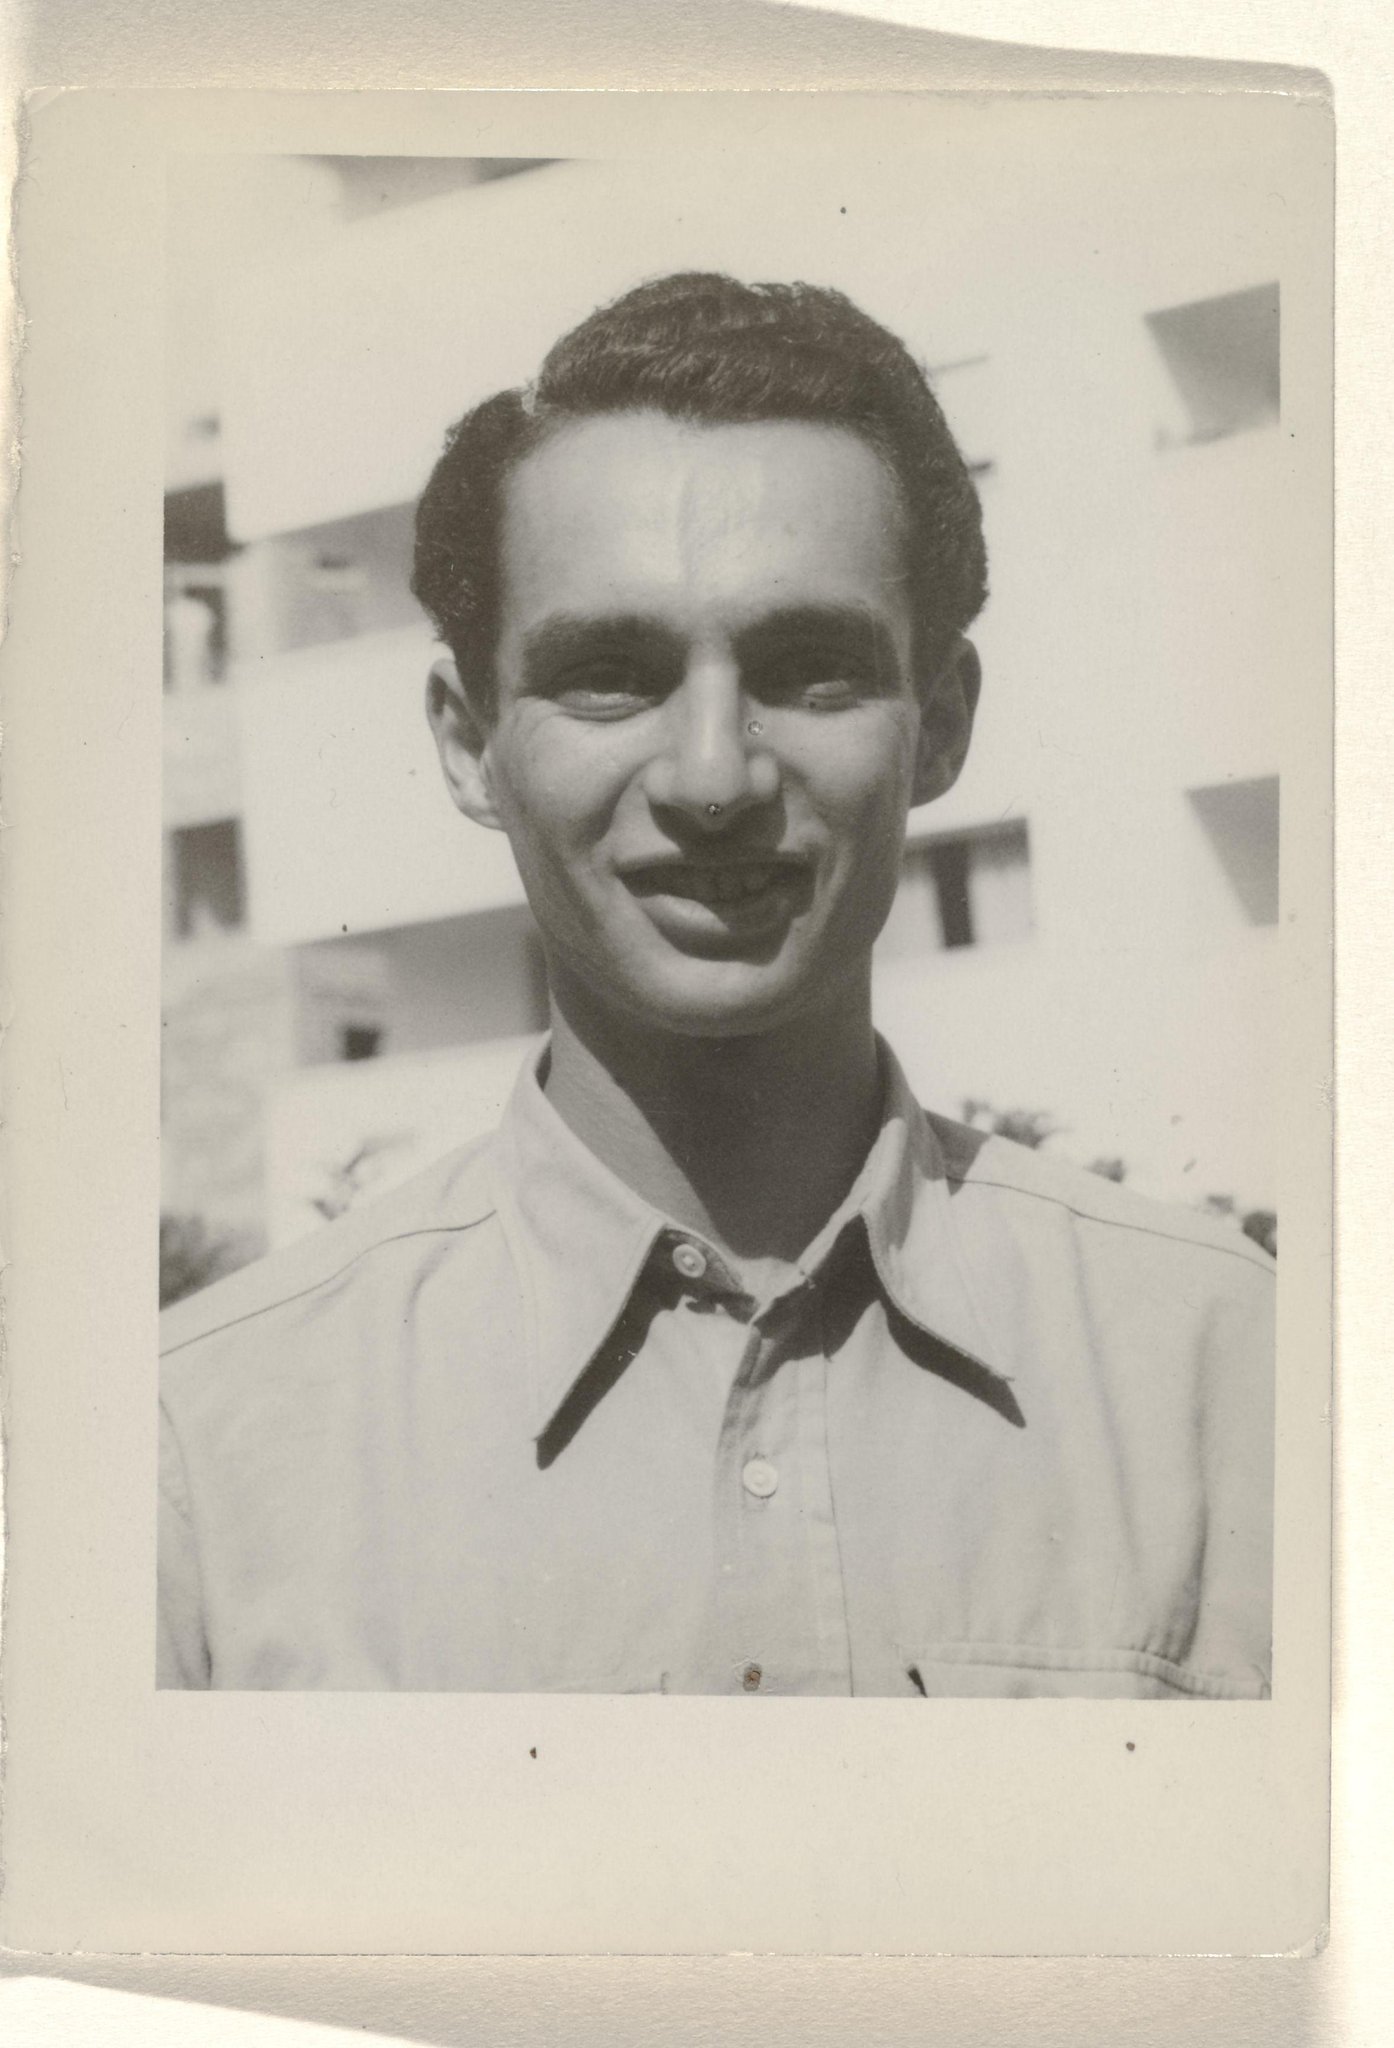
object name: photograph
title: Karl-Heinz Arndtheim, de tweede echtgenoot van Isabel Wachenheimer, lachend voor een gebouwencomplex 1949-1955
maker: Anonymous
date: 1949-1955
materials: photographic support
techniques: gelatin silver print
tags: karl-heinz arndtheim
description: Karl-Heinz Arndtheim, de tweede echtgenoot van Isabel Wachenheimer, lachend voor een gebouwencomplex.